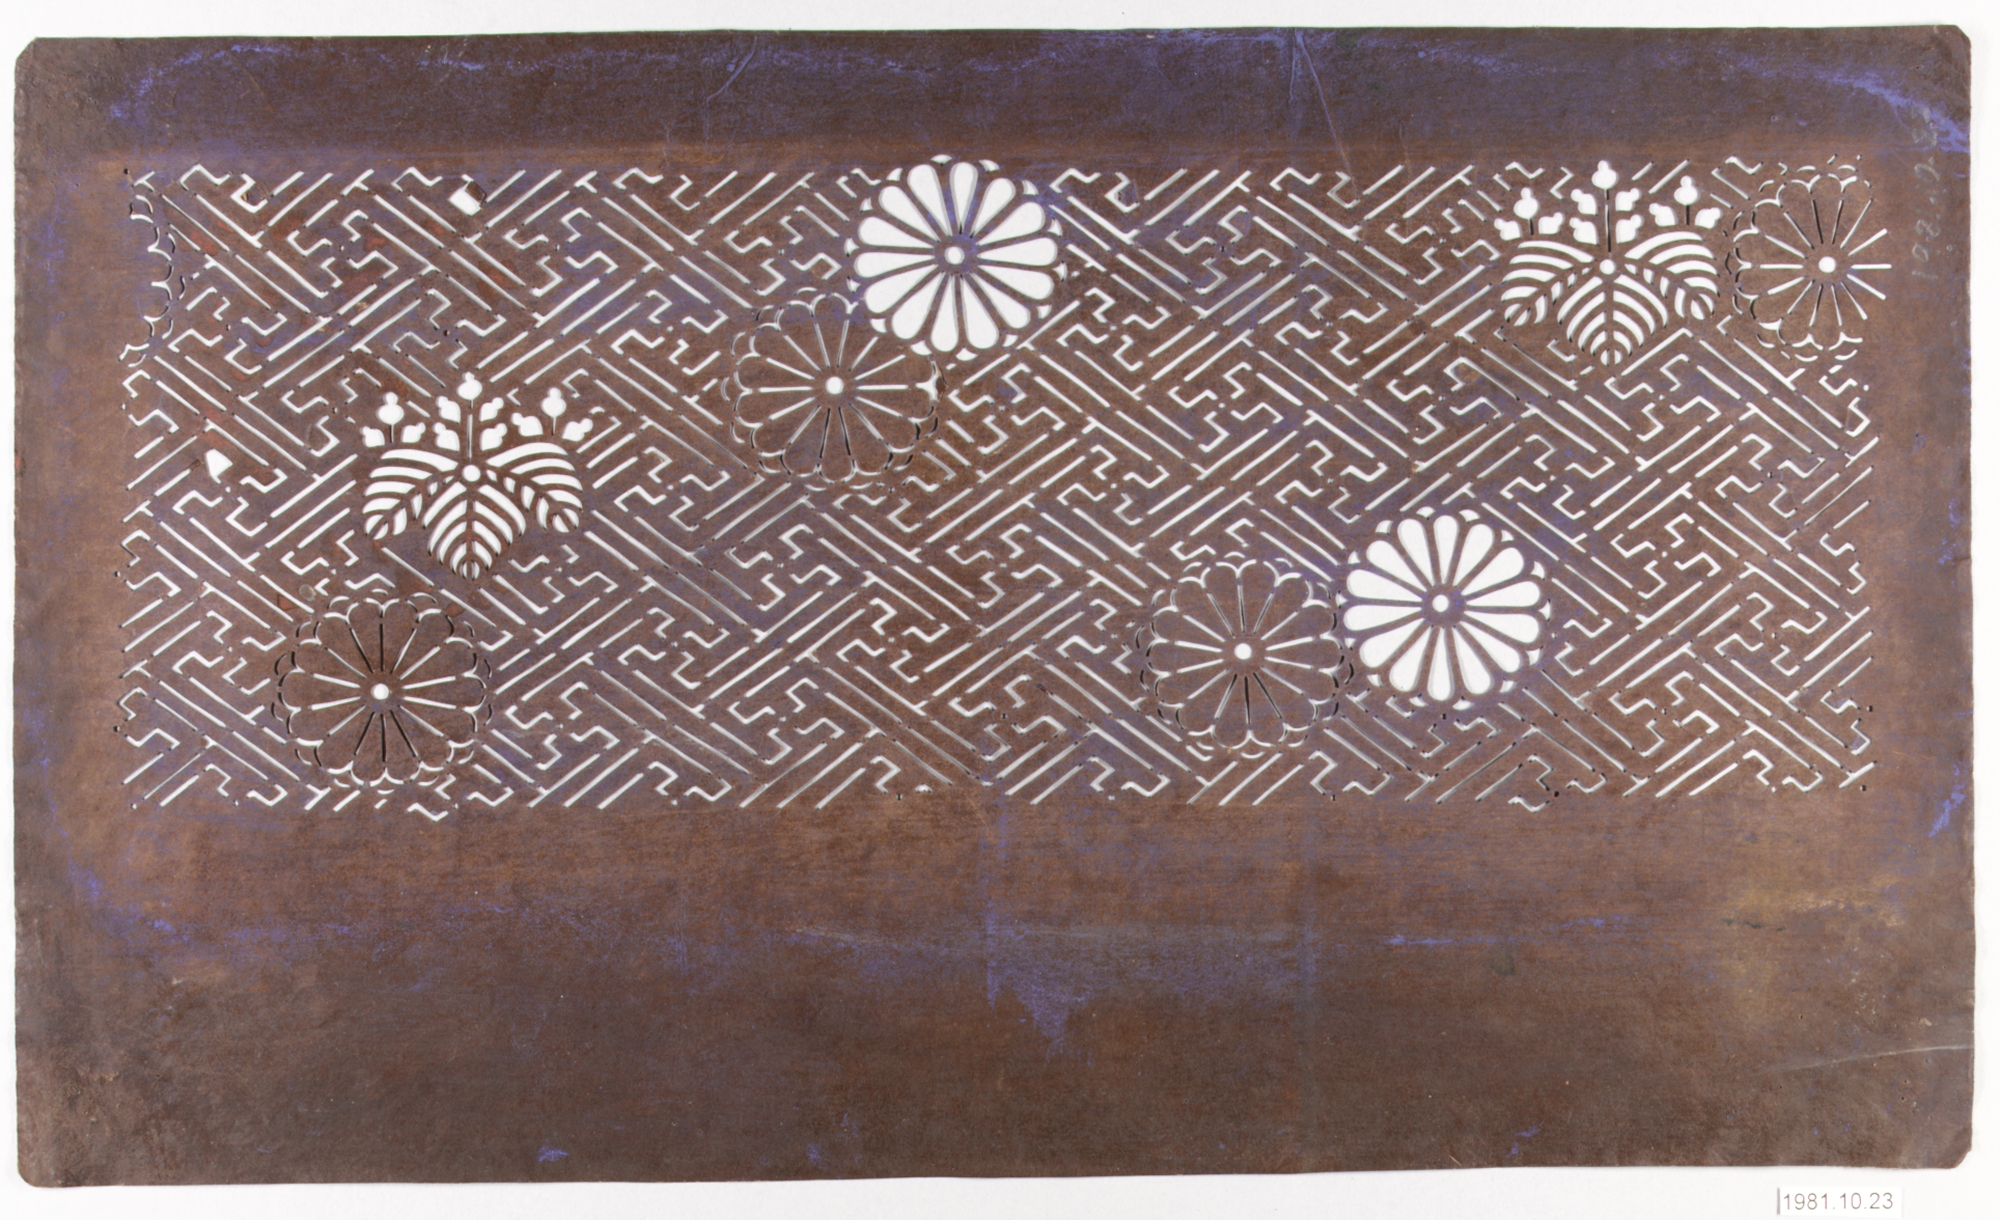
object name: stencil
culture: japanese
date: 1801-1900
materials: paper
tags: flowers